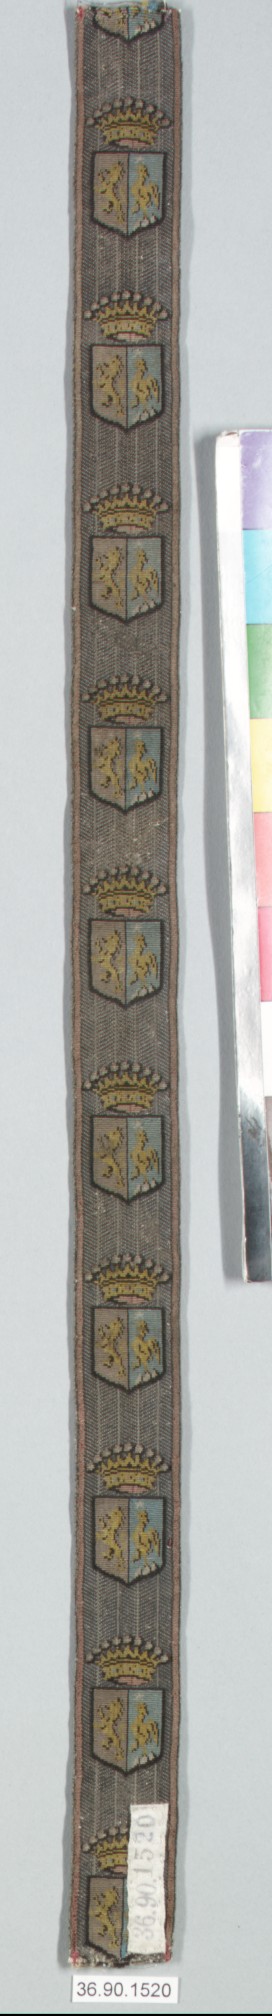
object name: galloon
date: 1701-1900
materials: silk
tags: coat of arms